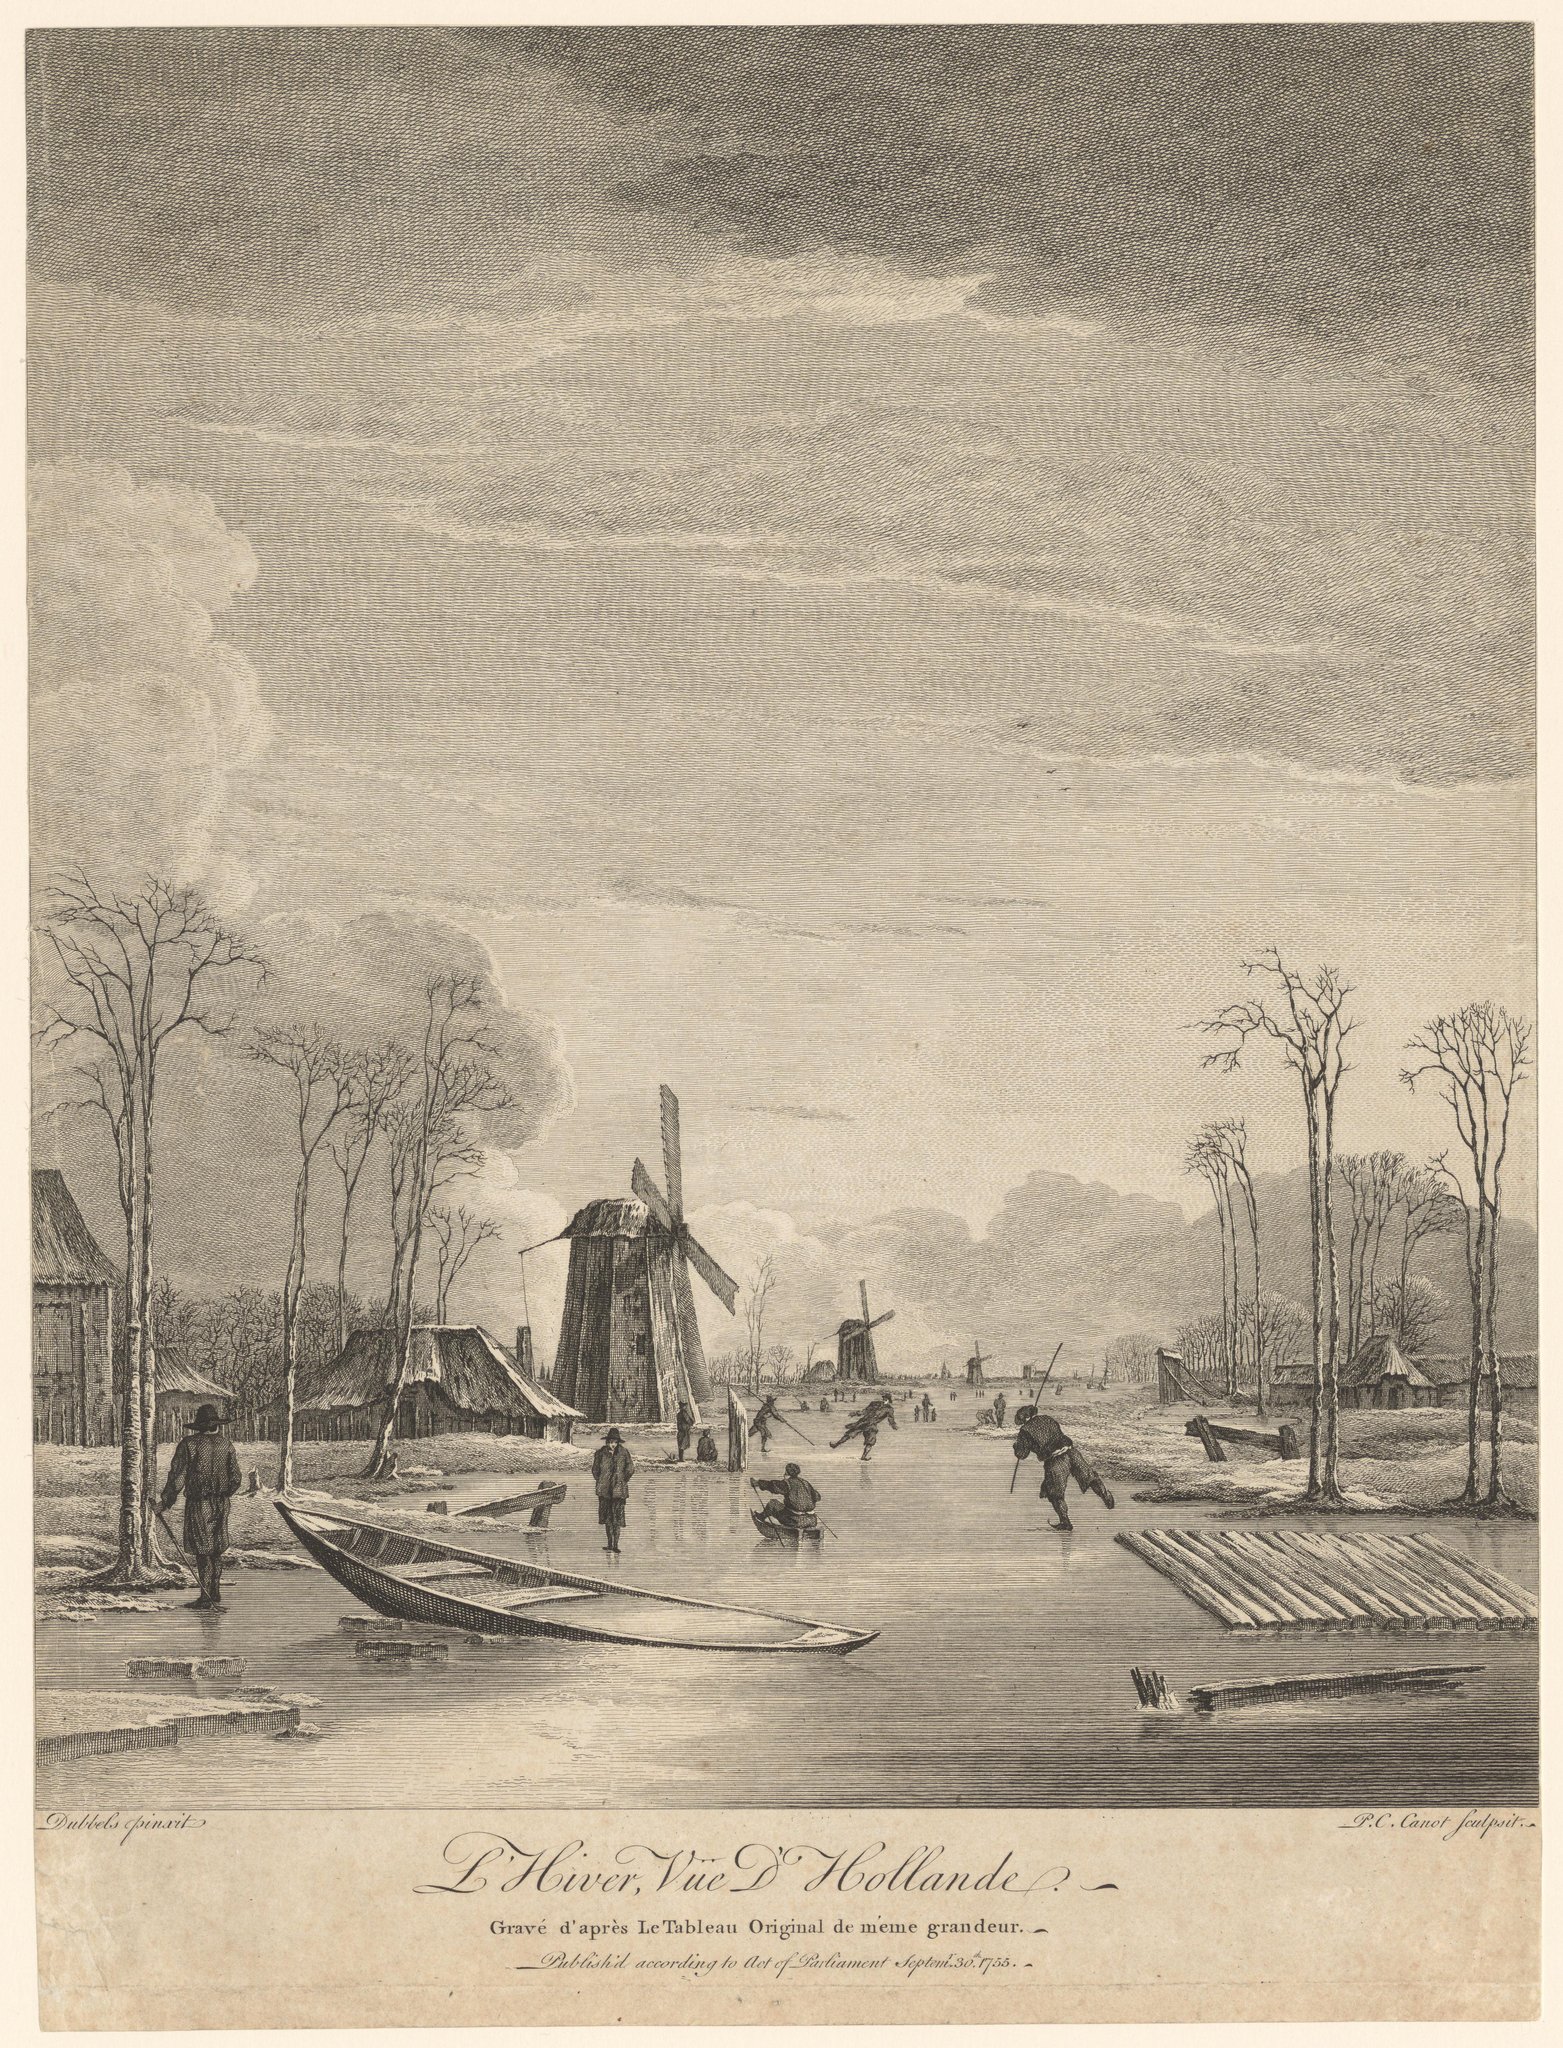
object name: print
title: Winterlandschap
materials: paper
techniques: engraving, etching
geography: london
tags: winter ~ human activities (the four seasons of the year), winter landscape; landscape symbolizing winter (the four seasons of the year), netherlands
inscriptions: collector's mark: Lugt 2228